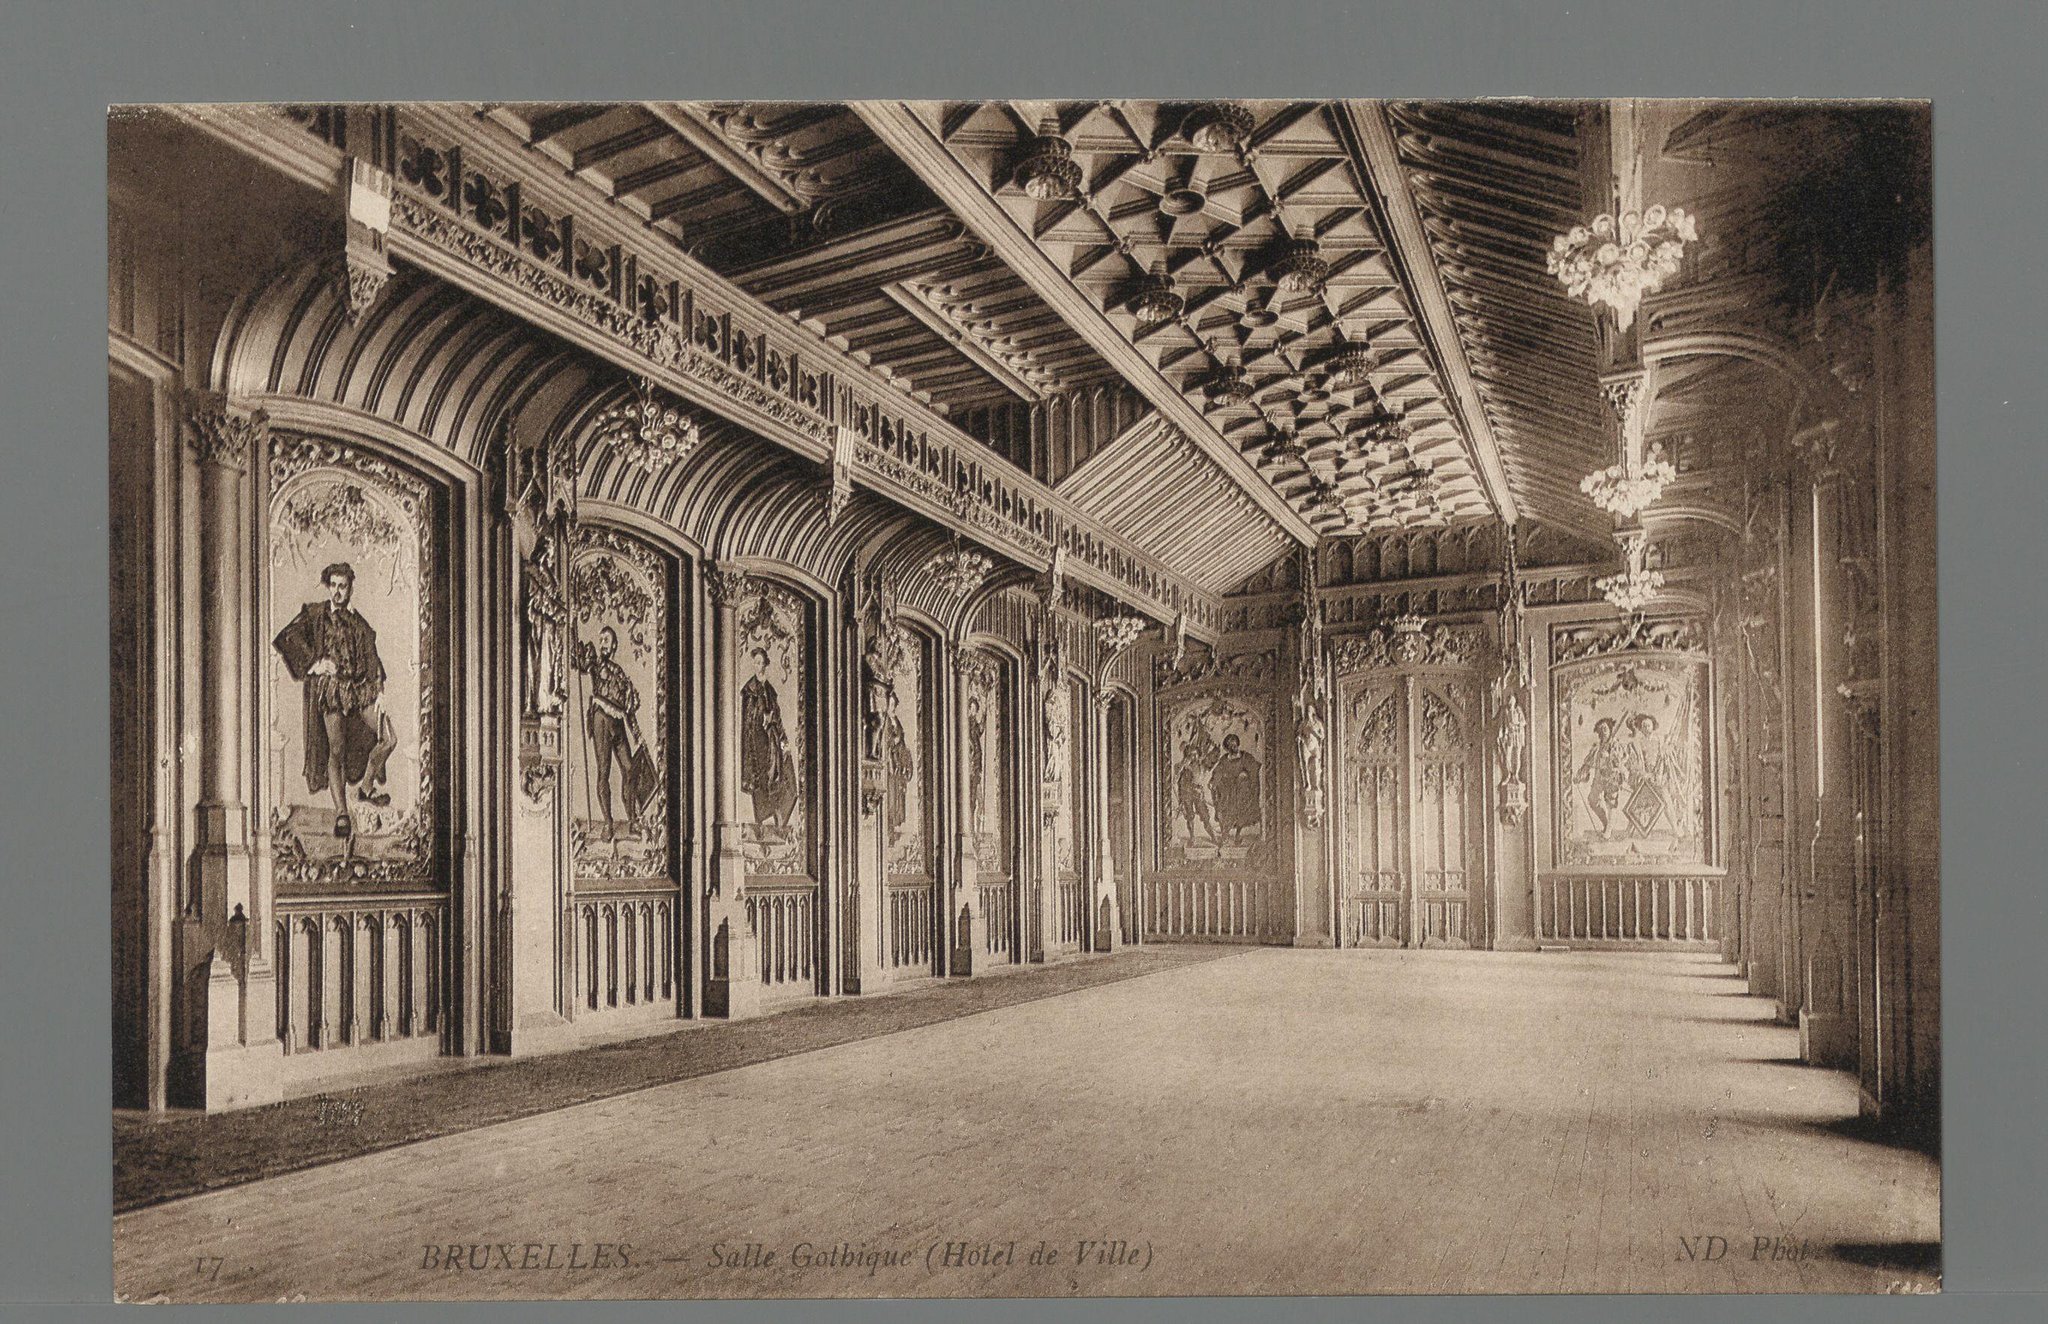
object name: photomechanical print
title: Bruxelles. Salle Gothique (Hôtel de Ville)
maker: Anonymous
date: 1906-1918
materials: cardboard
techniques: photograph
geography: paris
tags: townhall, interior ~ representation of a building